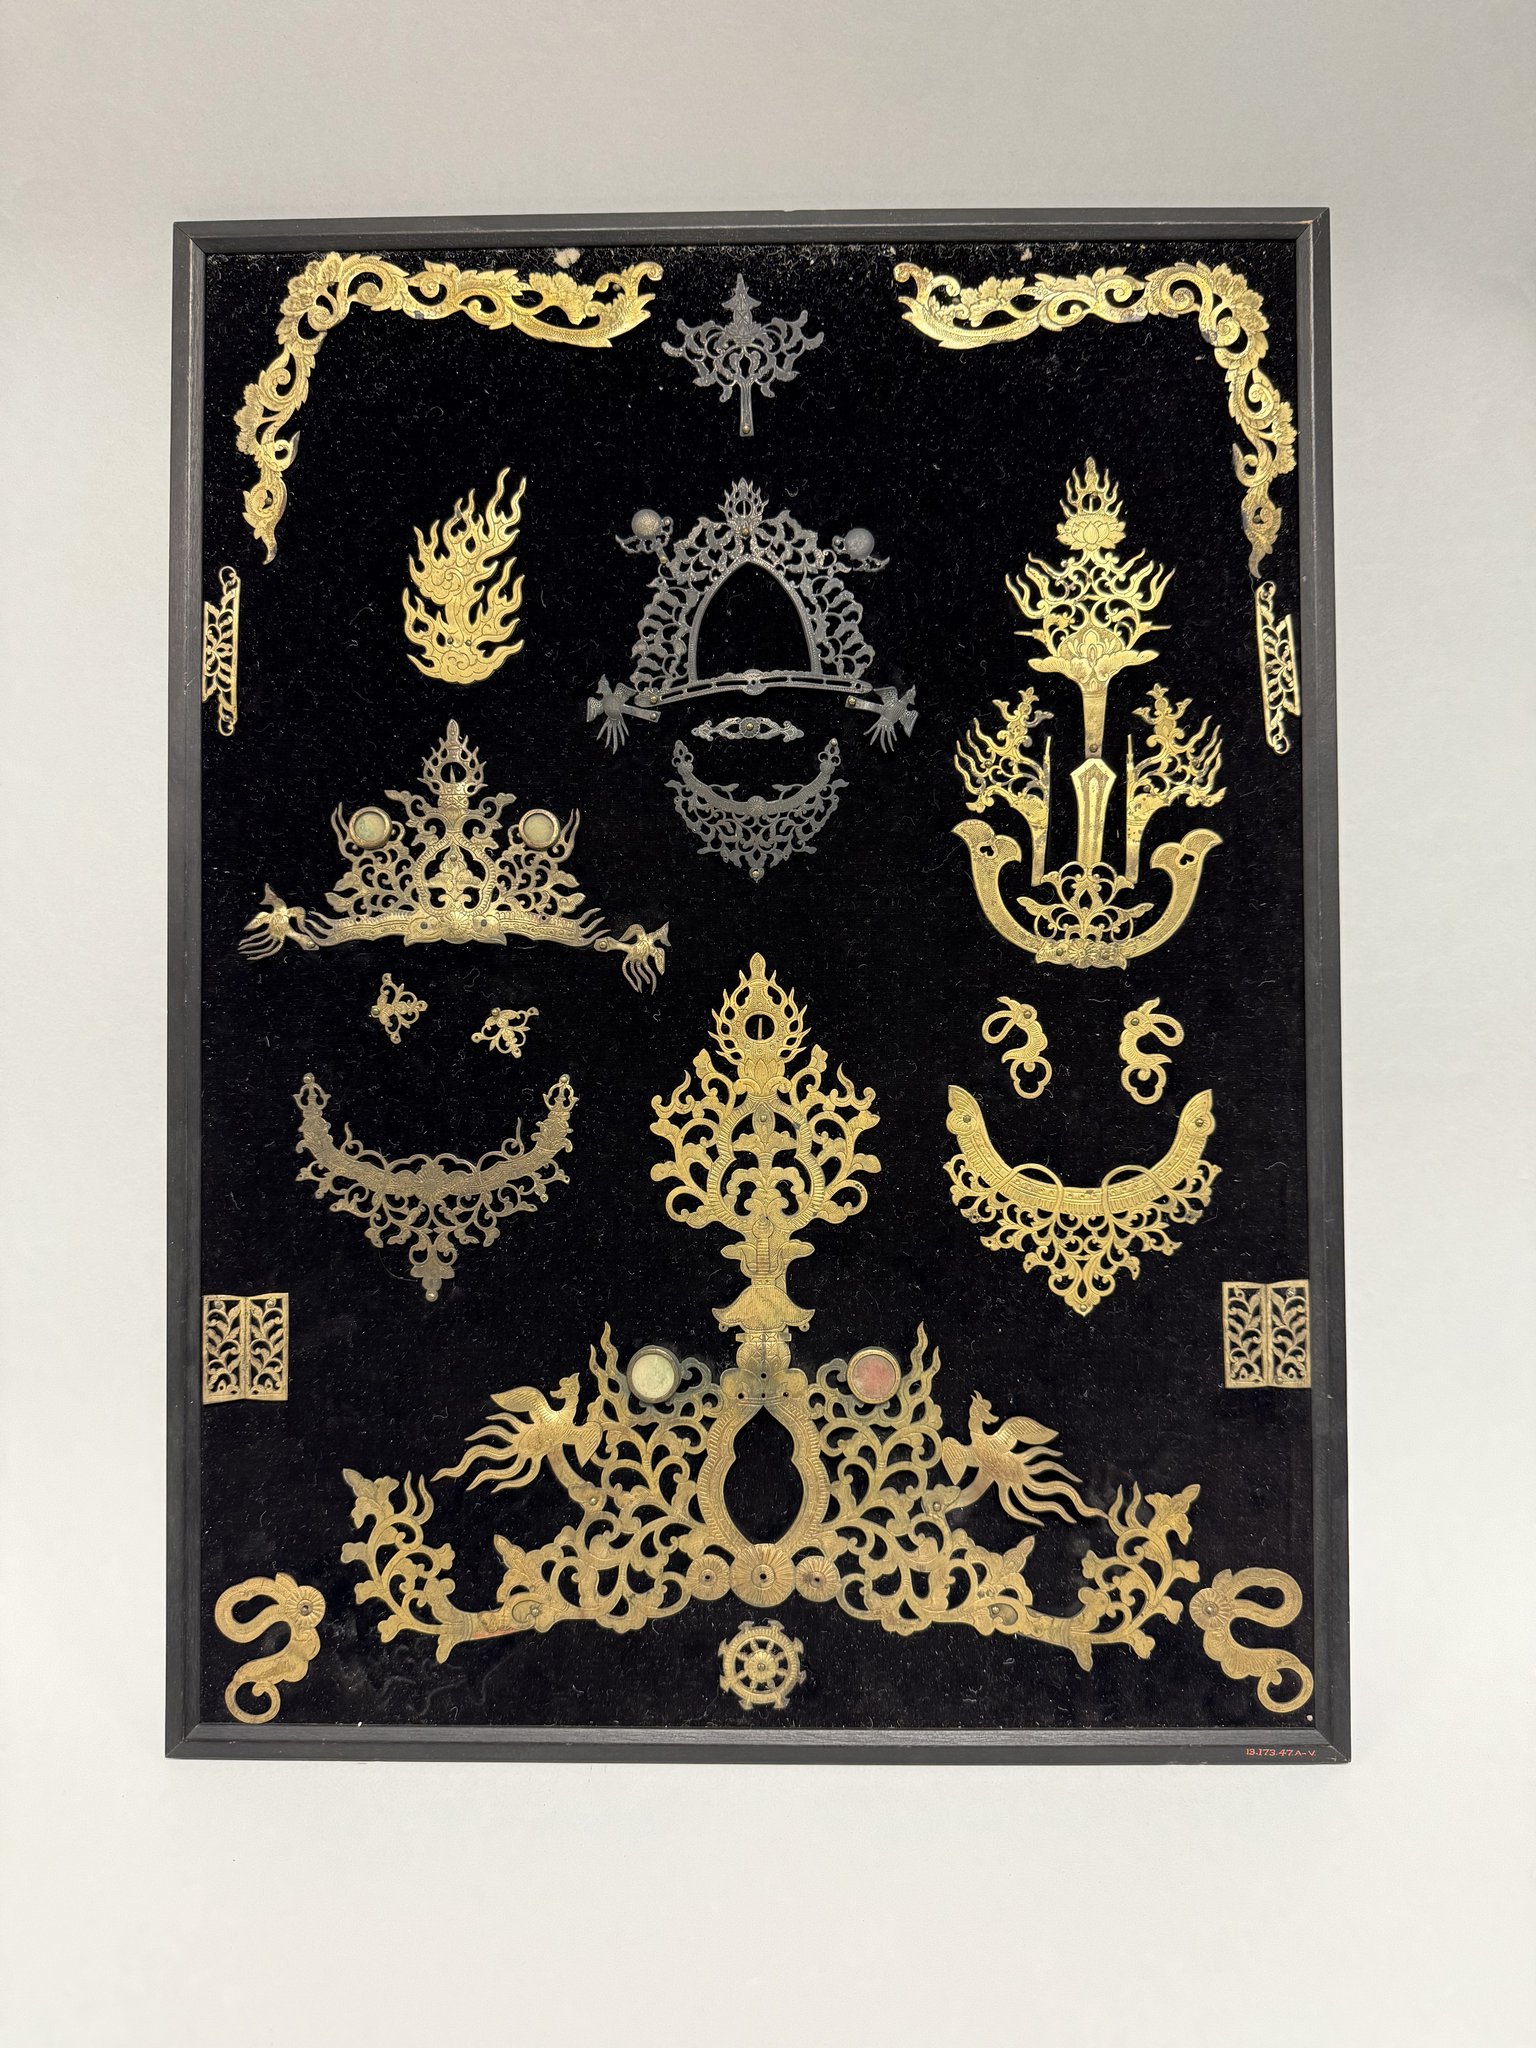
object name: ornament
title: Ornaments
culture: japanese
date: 1701-1900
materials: gilt bronze, silver